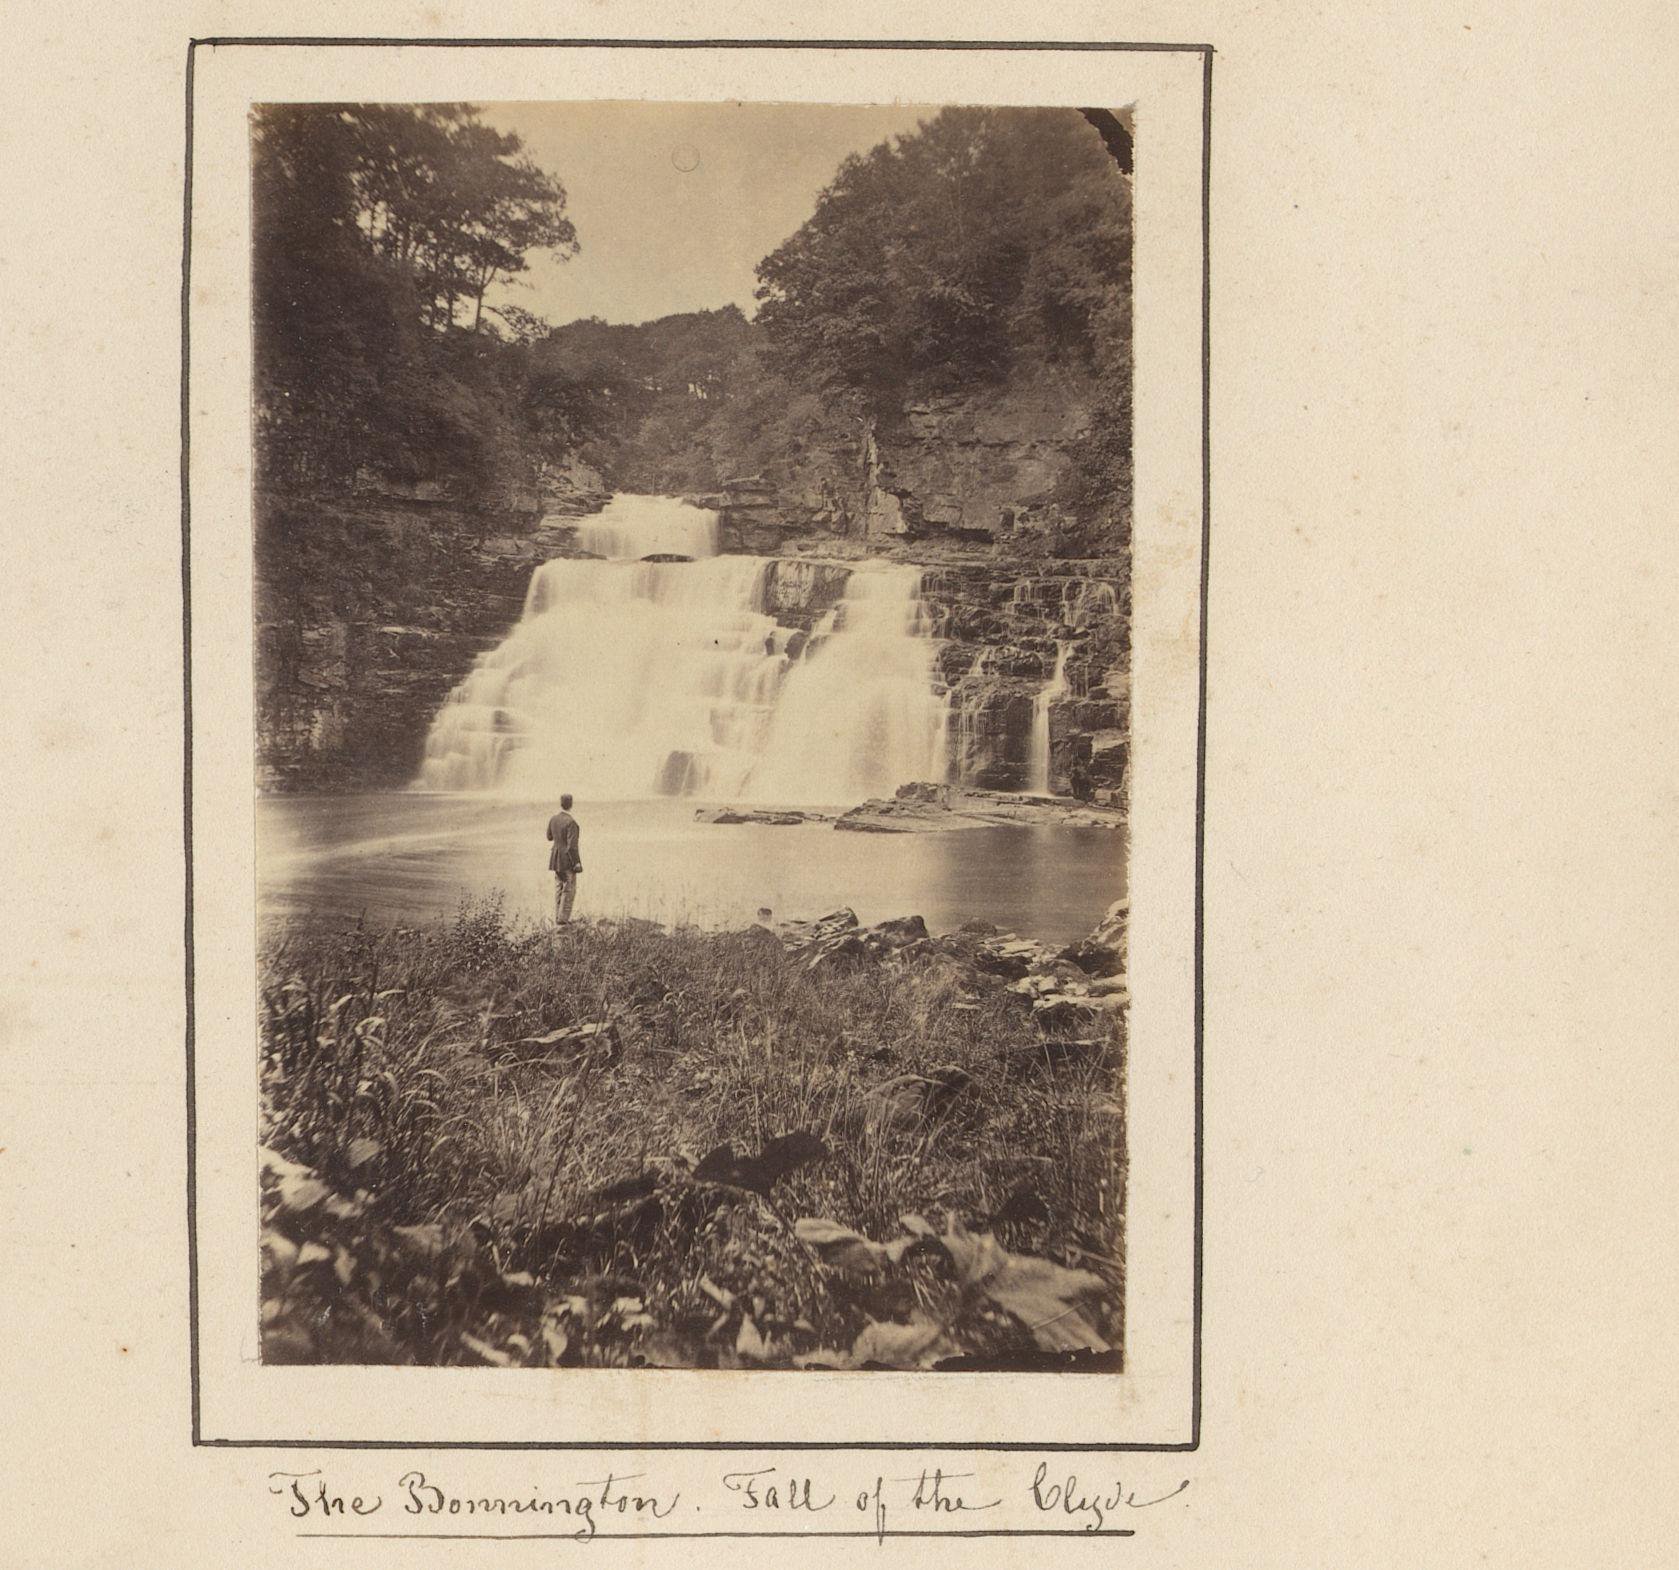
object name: photograph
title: The River Clyde near Lanark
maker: Anonymous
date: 1870-1890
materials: paper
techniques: albumen print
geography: clyde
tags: rapids